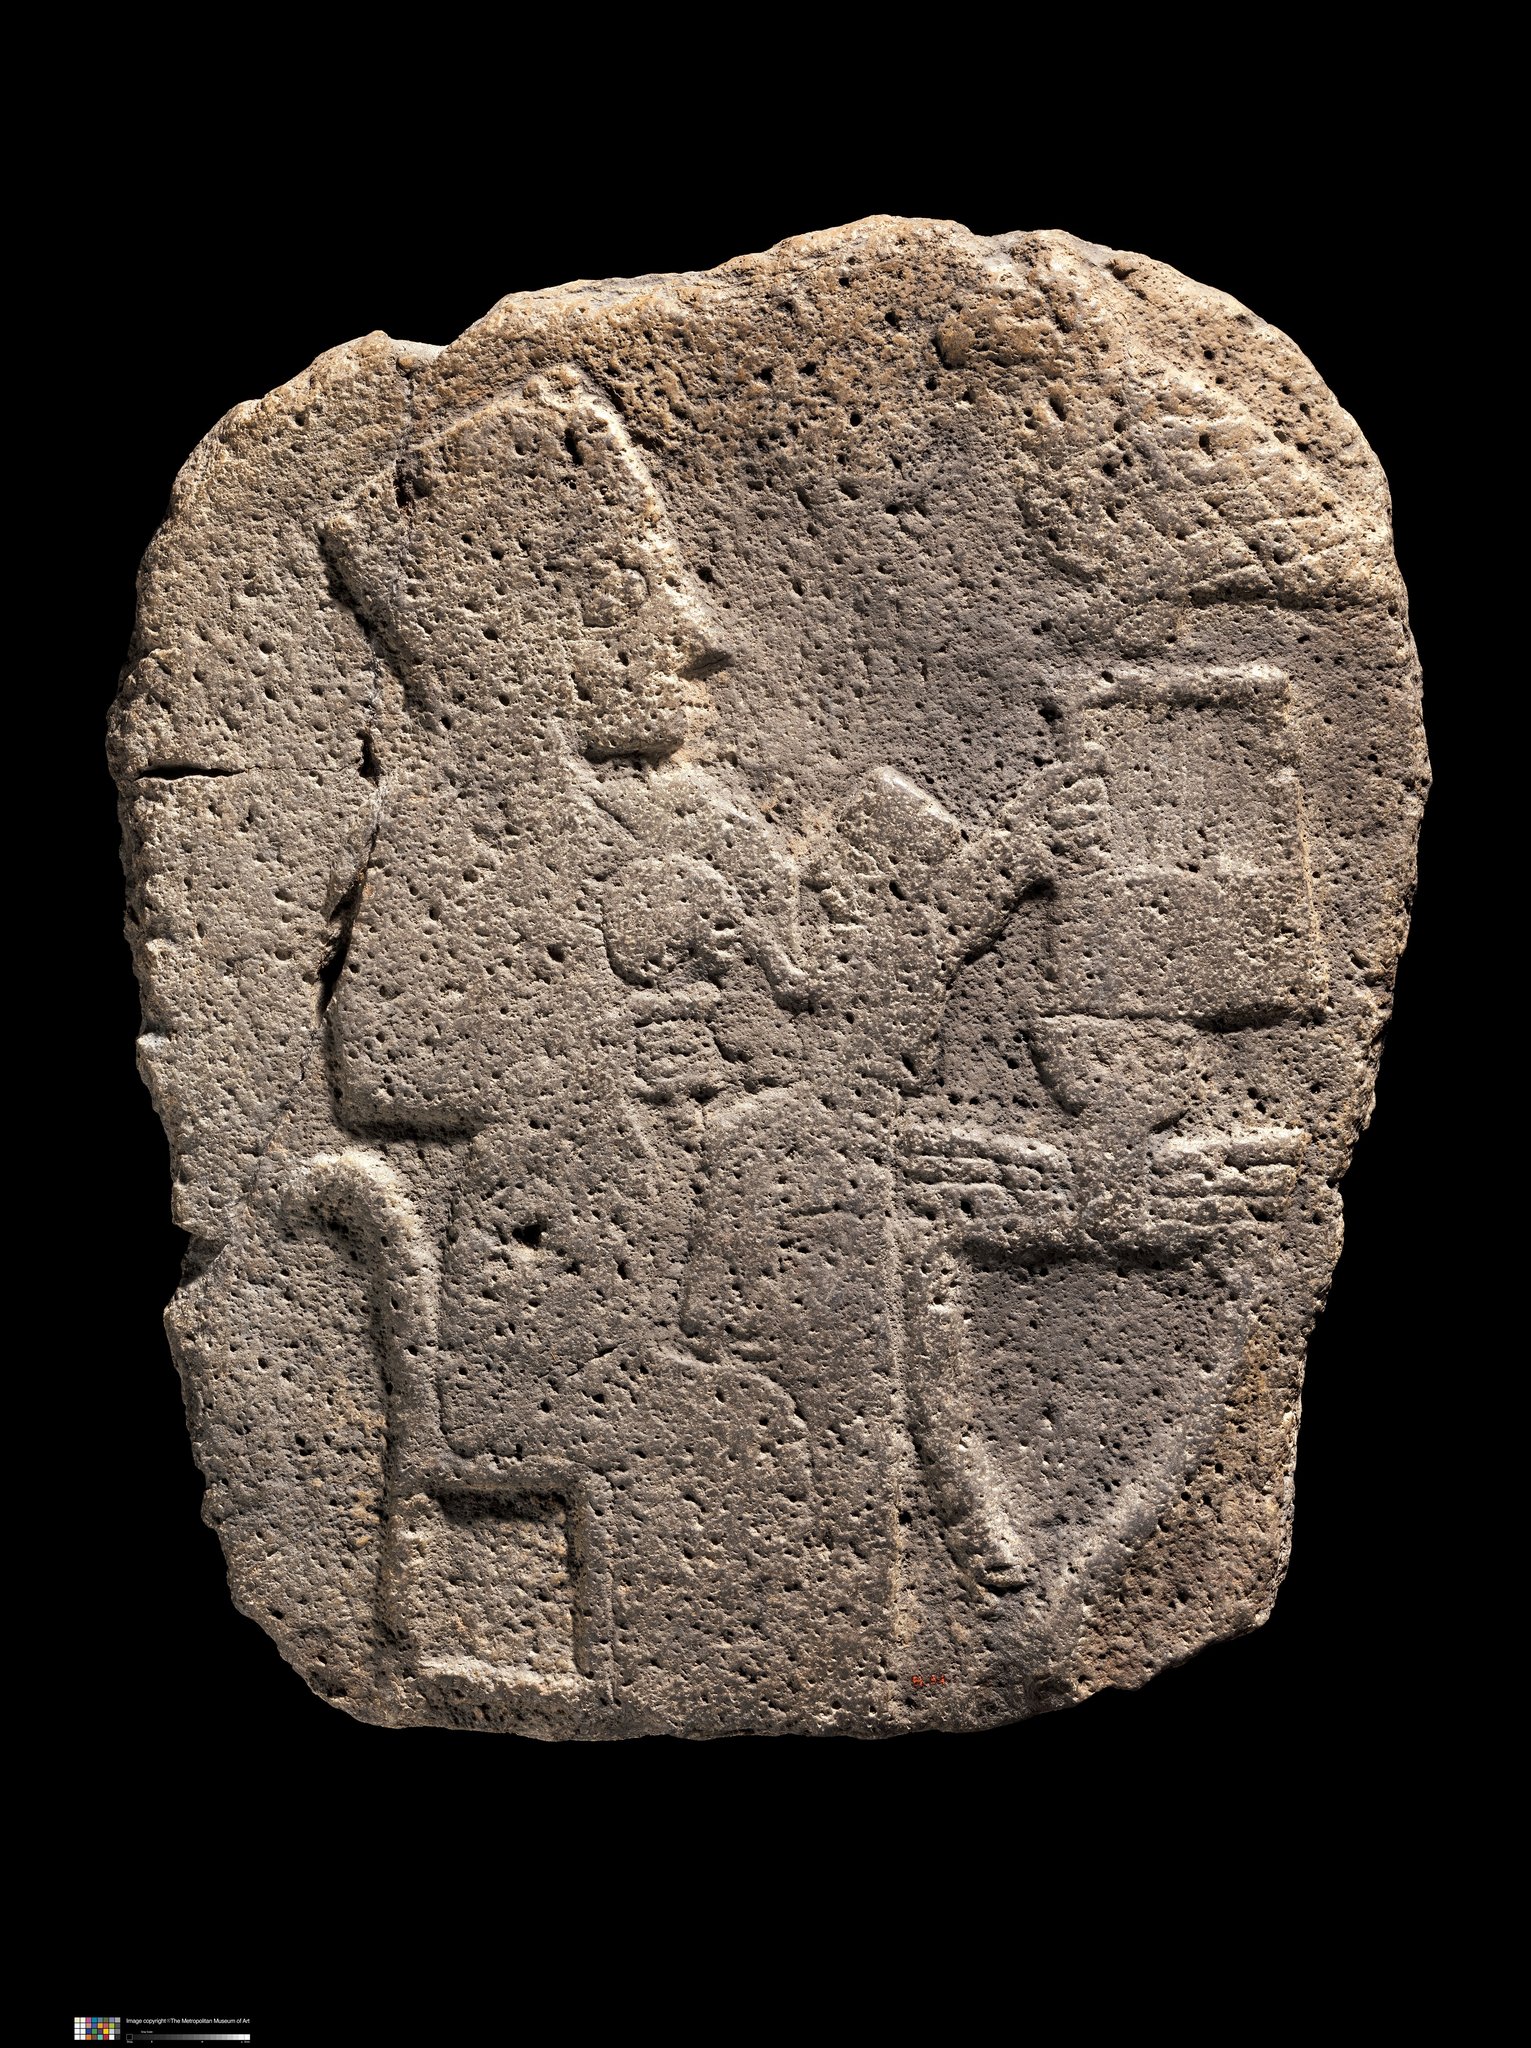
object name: relief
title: Relief: woman seated at a table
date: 1000-668 BCE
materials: stone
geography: anatolia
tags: women